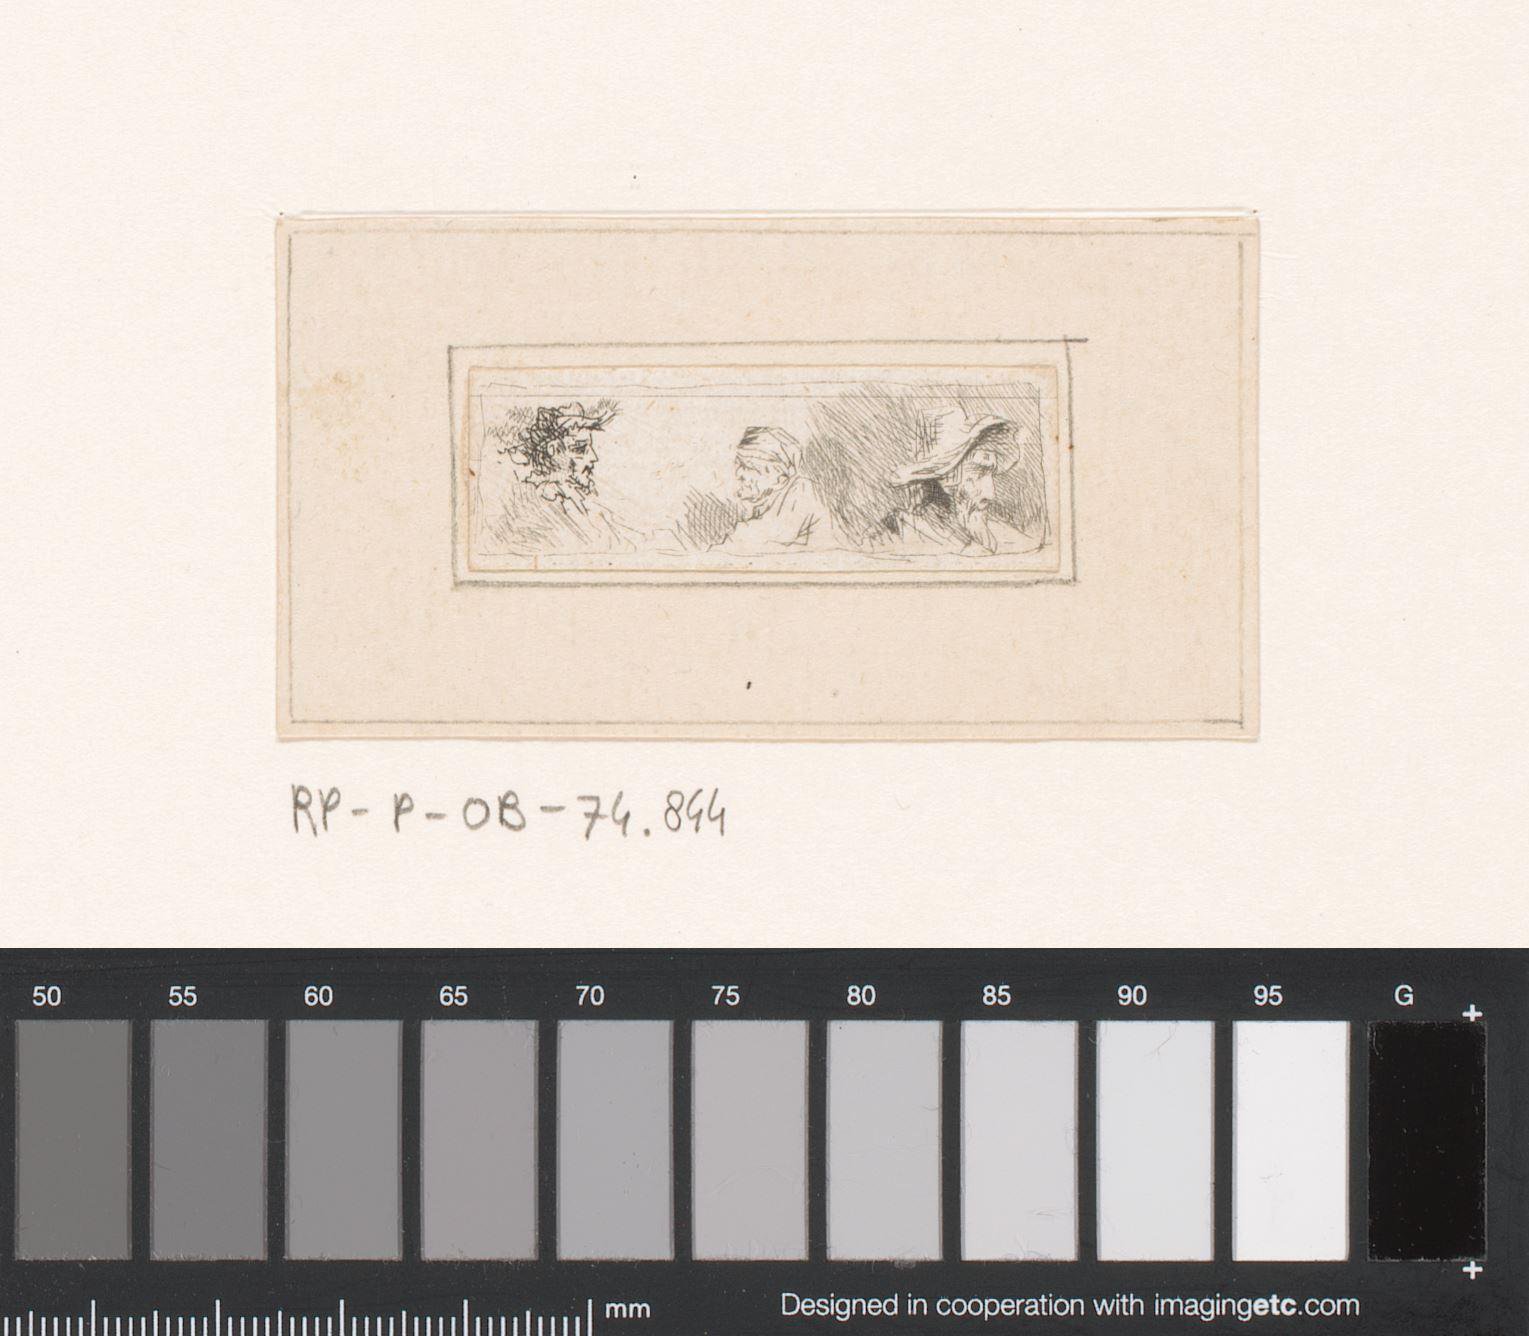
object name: print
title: Drie mannenkoppen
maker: Anonymous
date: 1700-1800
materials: paper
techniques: etching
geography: france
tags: head (human), head-gear: cap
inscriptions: collector's mark: Lugt 240